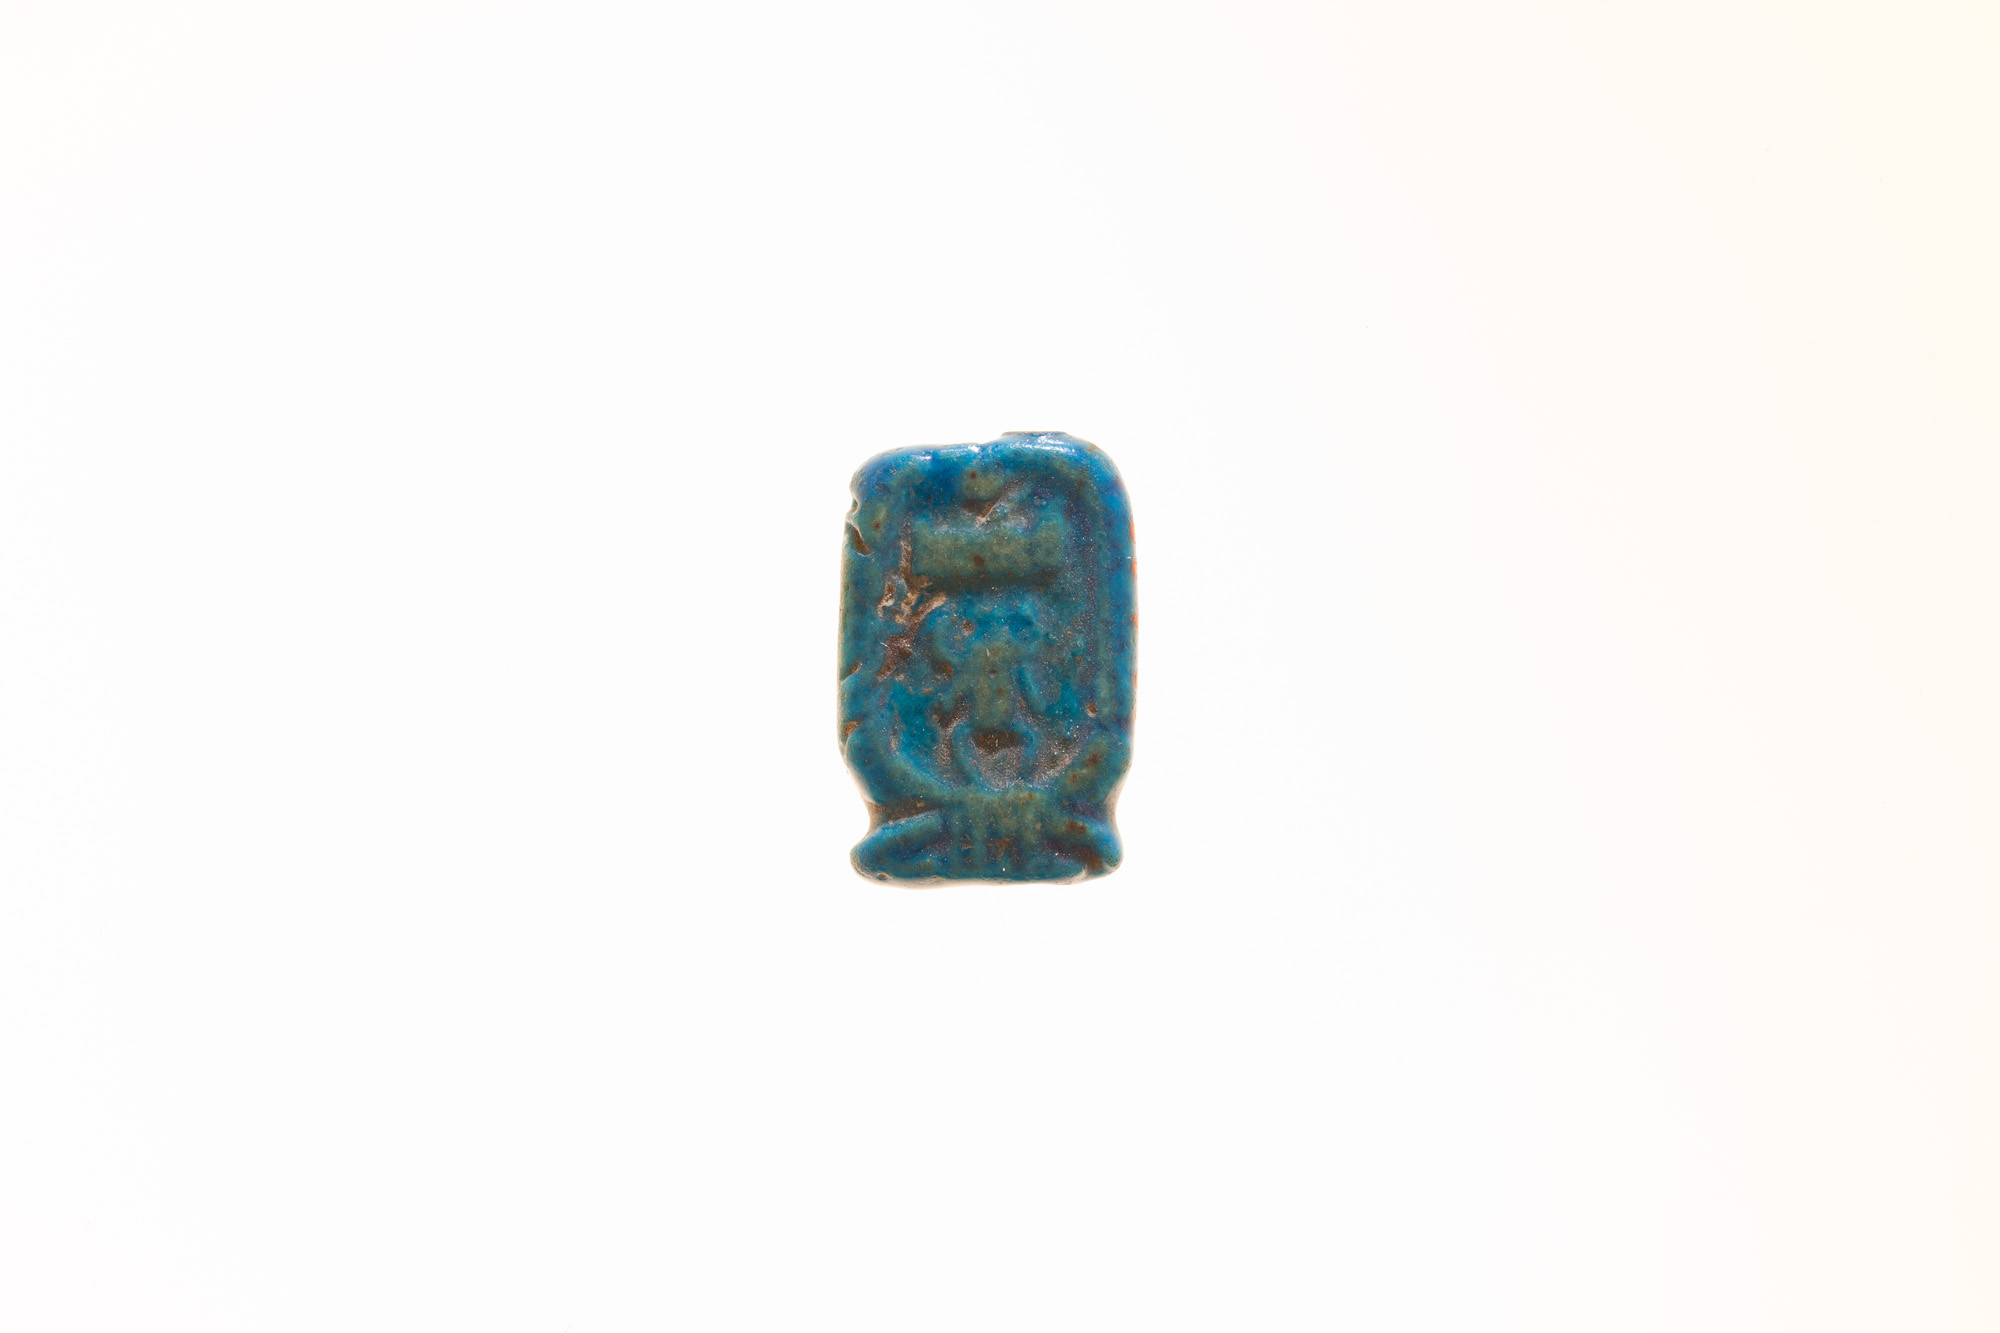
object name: amulet, cartouche, menkheperre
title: Cartouche Amulet Incribed with the Name Menkheperre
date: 1479-1458 BCE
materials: faience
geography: egypt